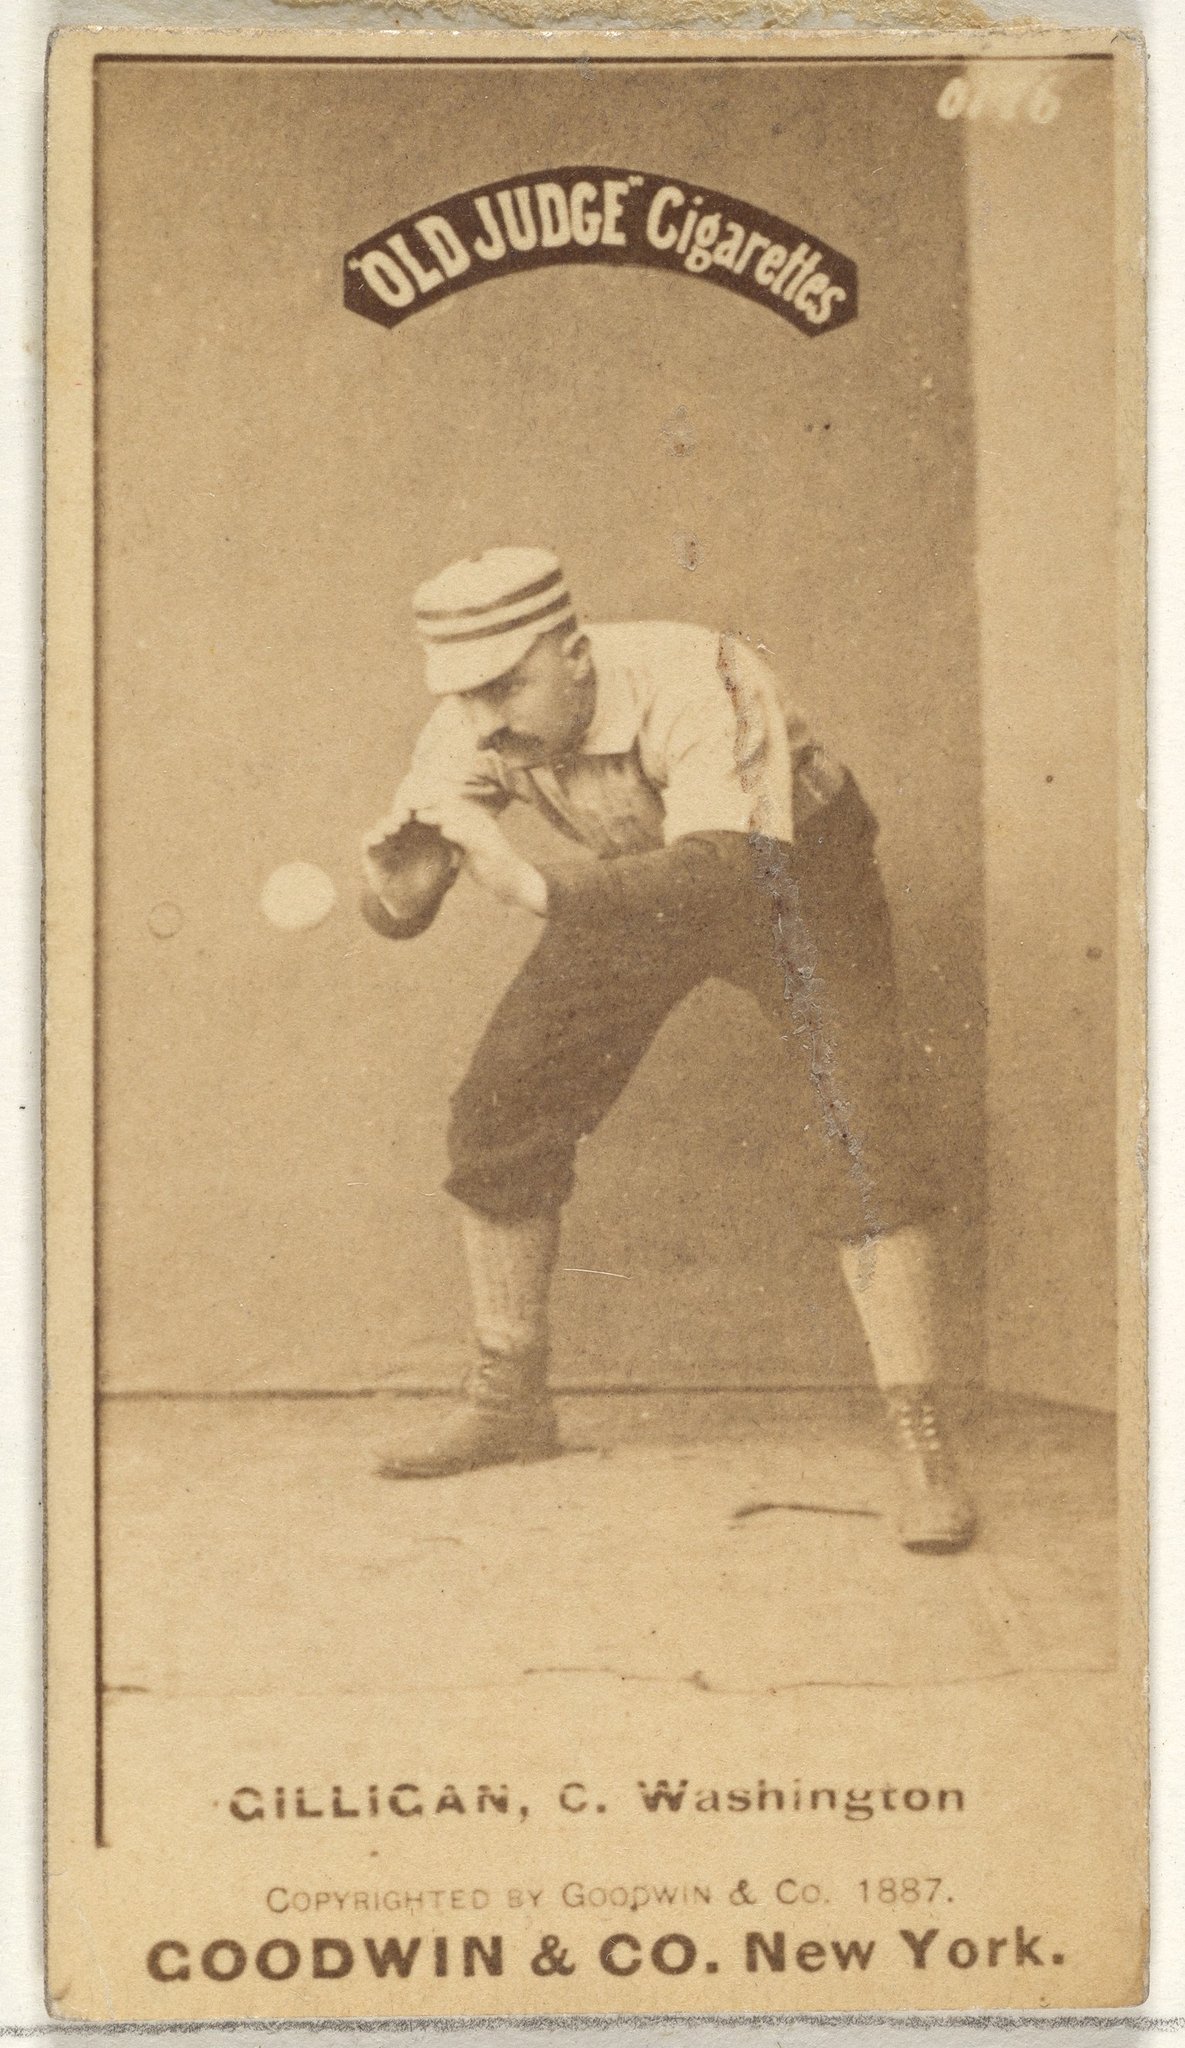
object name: baseball card, photograph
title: Andrew Bernard "Barney" Gilligan, Catcher, Washington Nationals, from the Old Judge series (N172) for Old Judge Cigarettes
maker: goodwin & company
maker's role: publisher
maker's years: 1850-1950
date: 1887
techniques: albumen silver print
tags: men,baseball,athletes